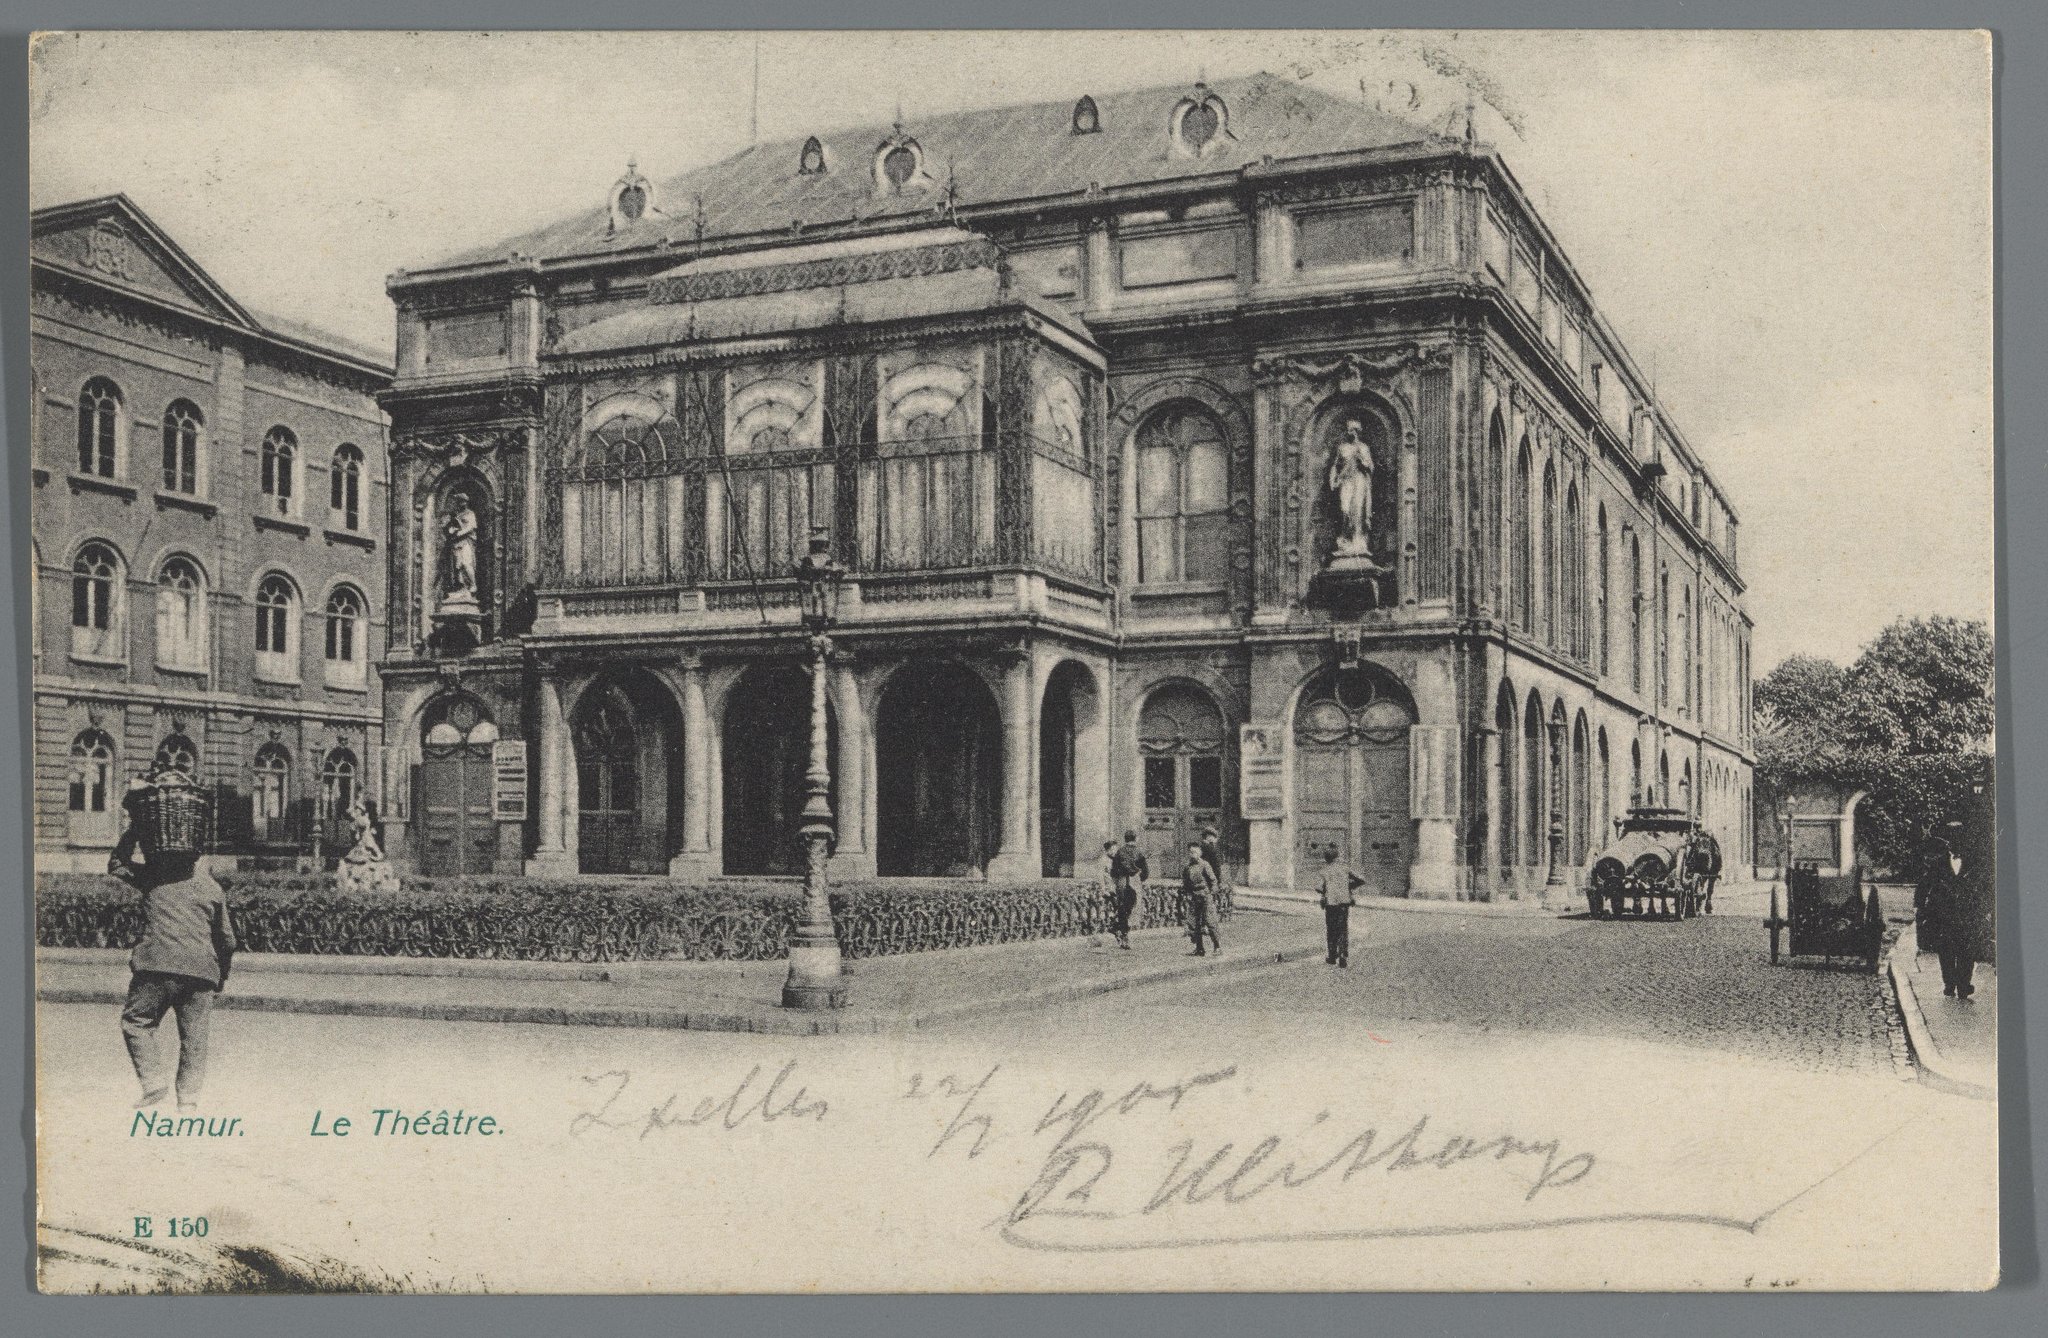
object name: postcard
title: Namur, Le Théâtre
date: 1920-1950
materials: photographic support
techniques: photograph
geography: brussels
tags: namen (stad)